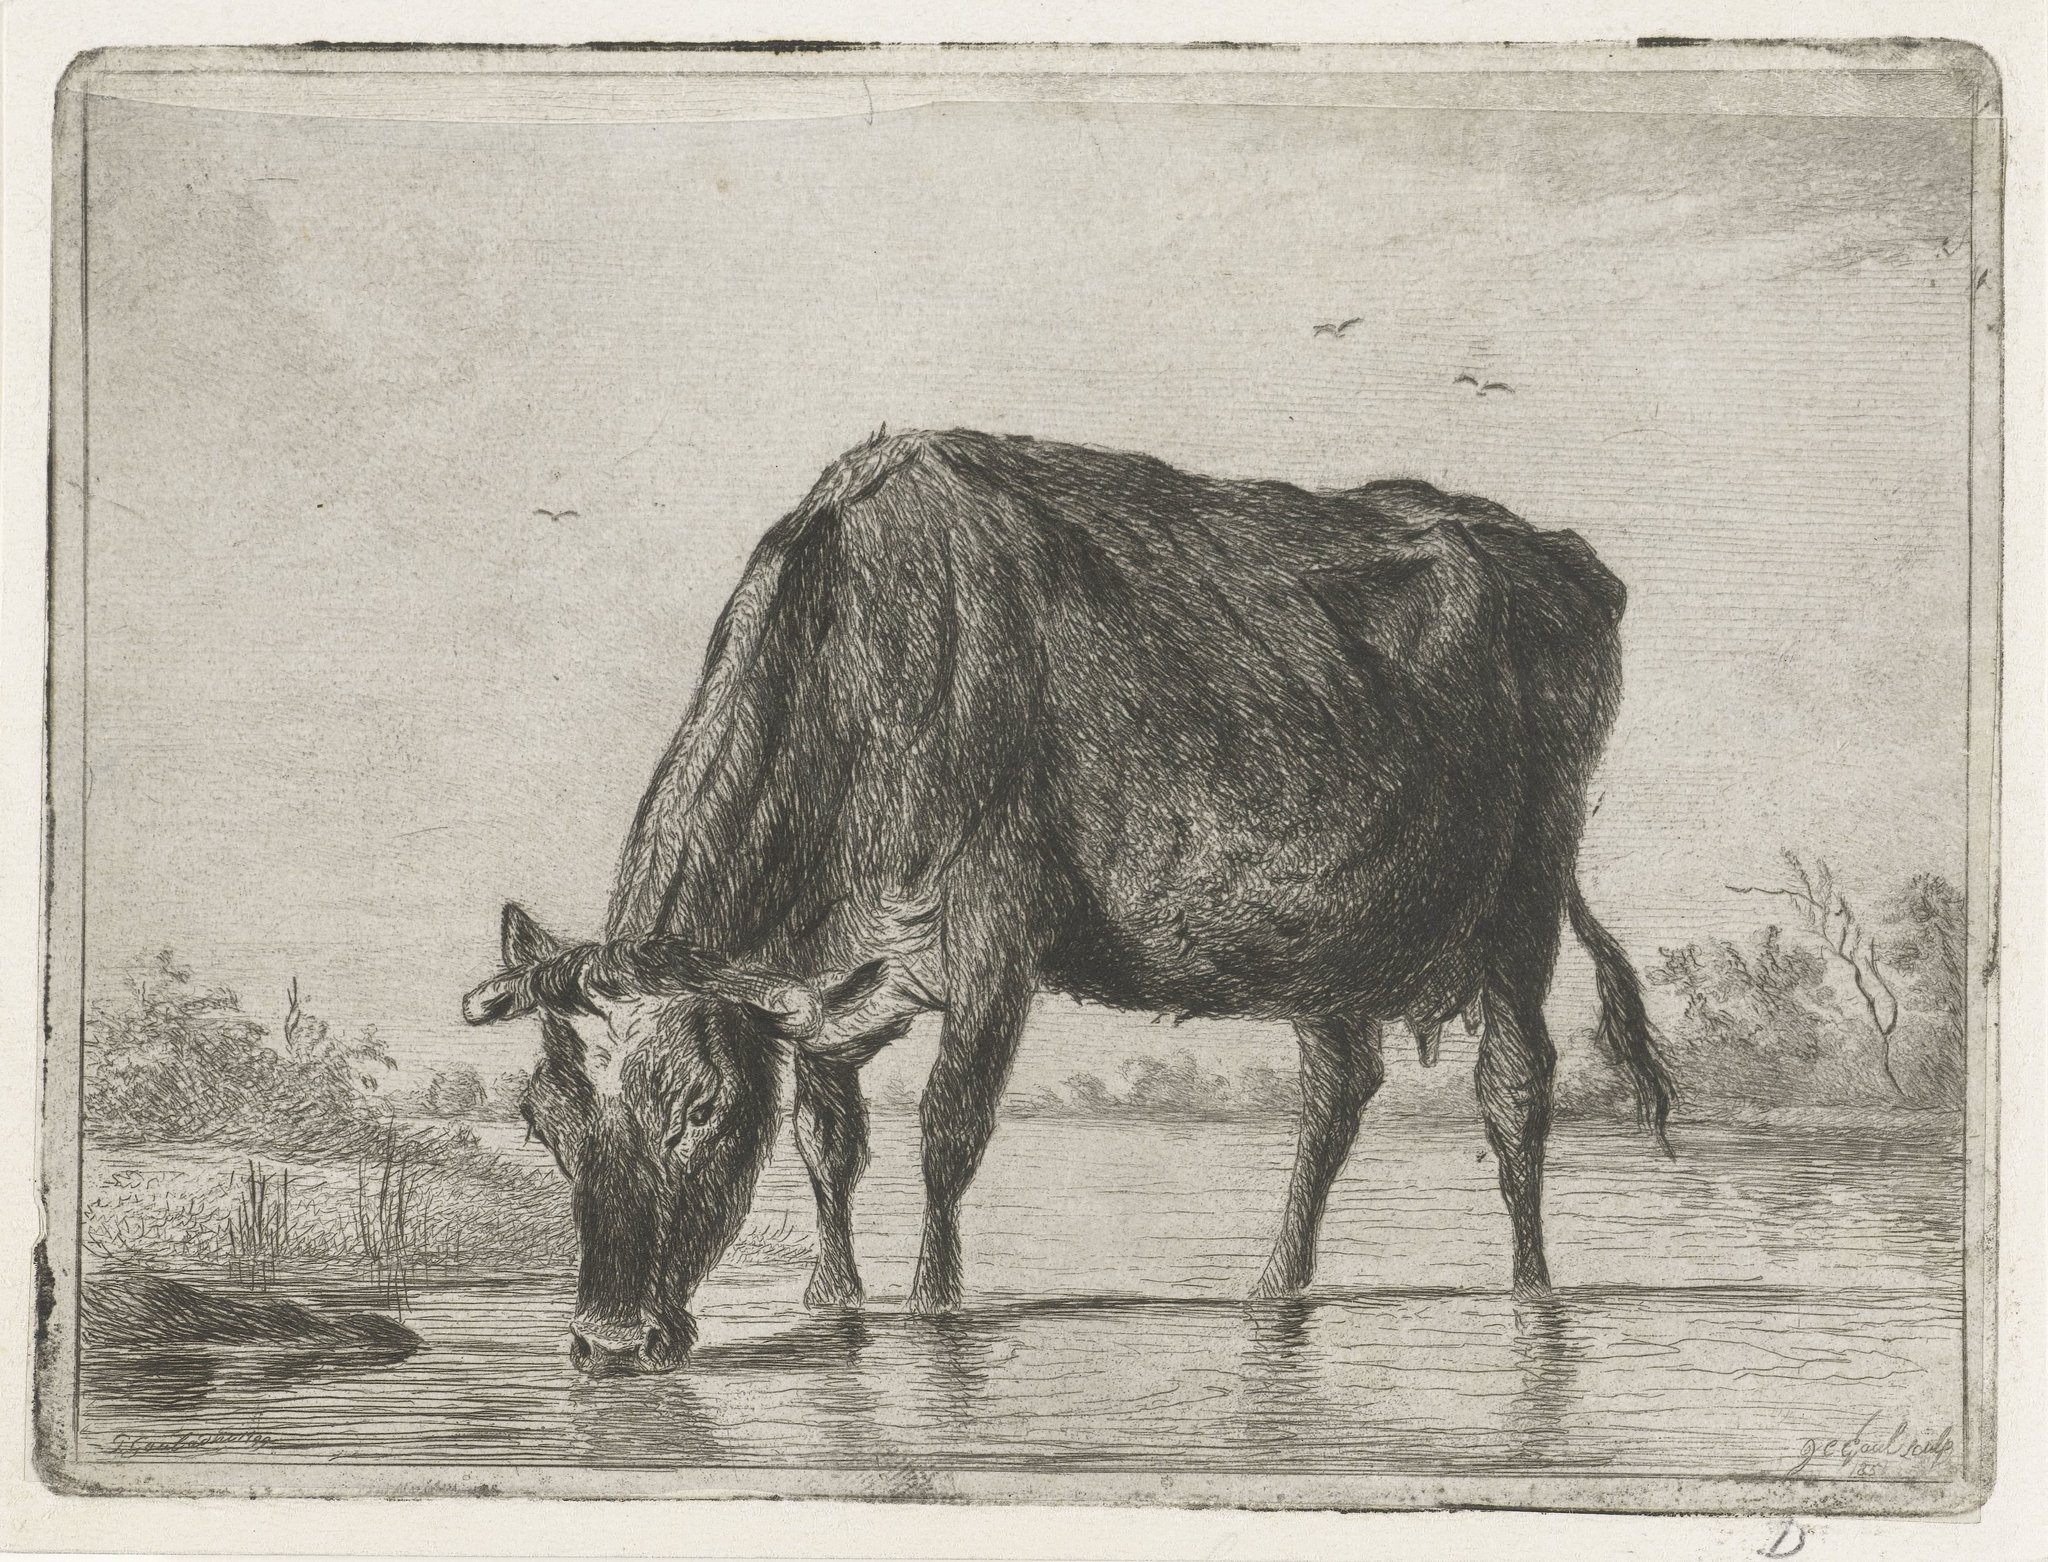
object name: print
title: Drinkende koe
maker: jacobus cornelis gaal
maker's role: print maker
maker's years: 1796-1866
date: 1851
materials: paper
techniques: etching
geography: netherlands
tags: cow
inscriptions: collector's mark: Lugt 2228